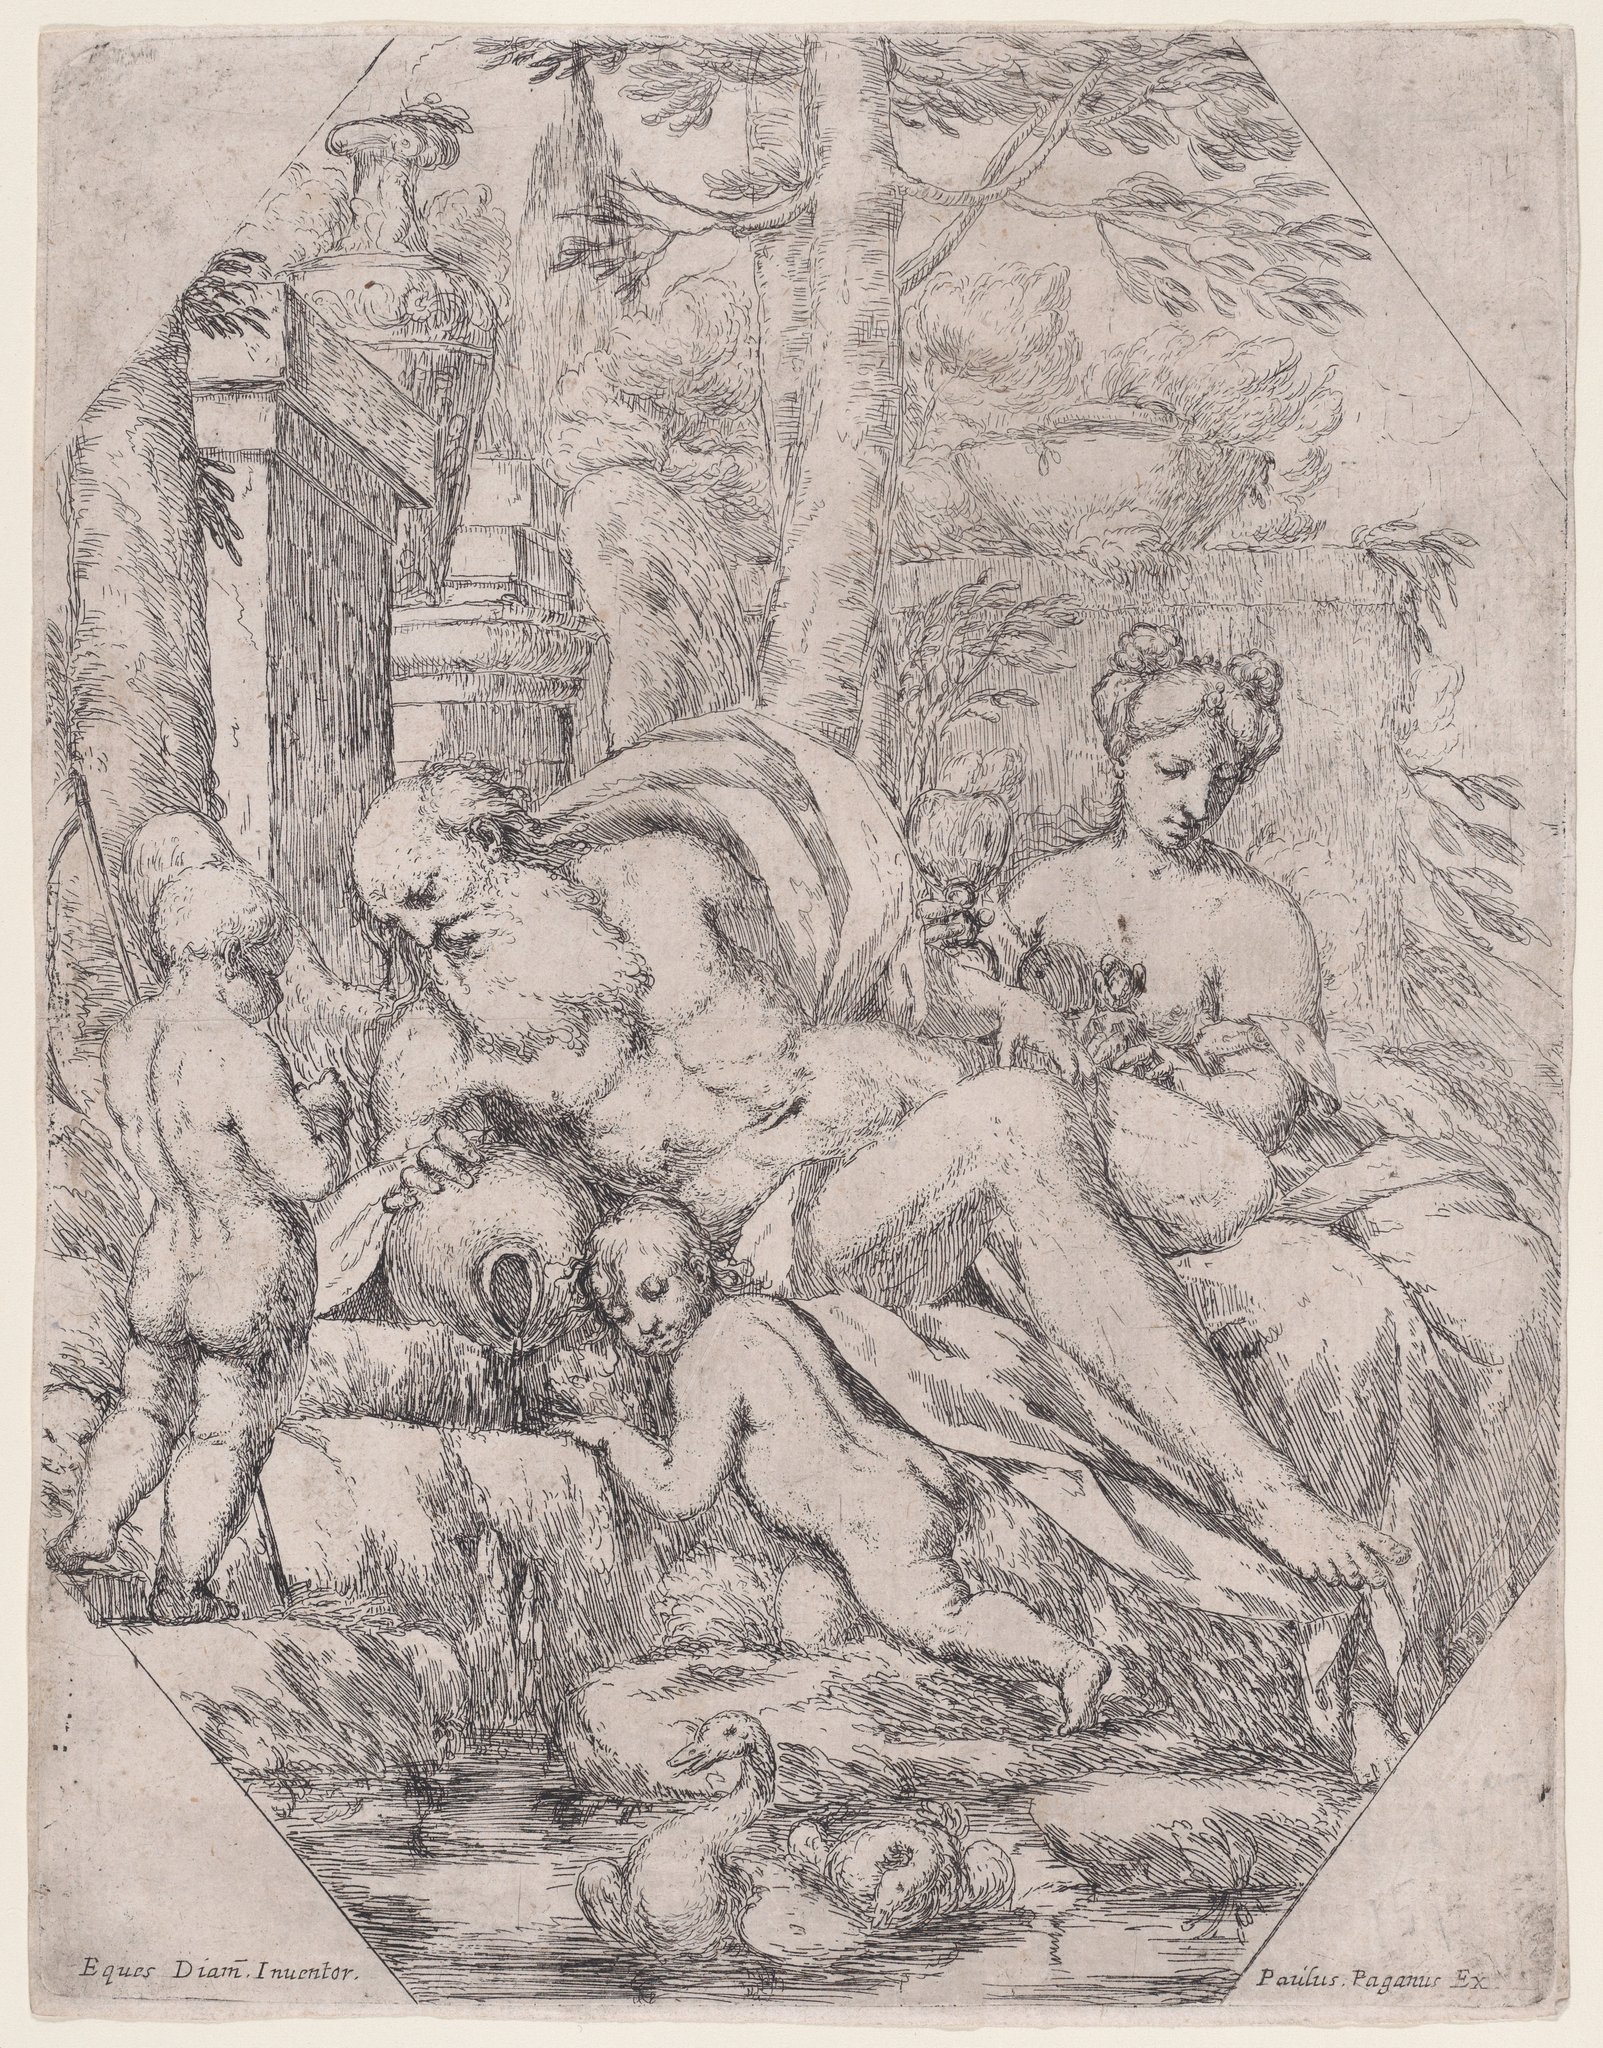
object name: print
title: Saturn and Rhea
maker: giuseppe diamantini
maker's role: artist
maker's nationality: italian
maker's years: 1621-1705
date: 1680-1700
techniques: etching